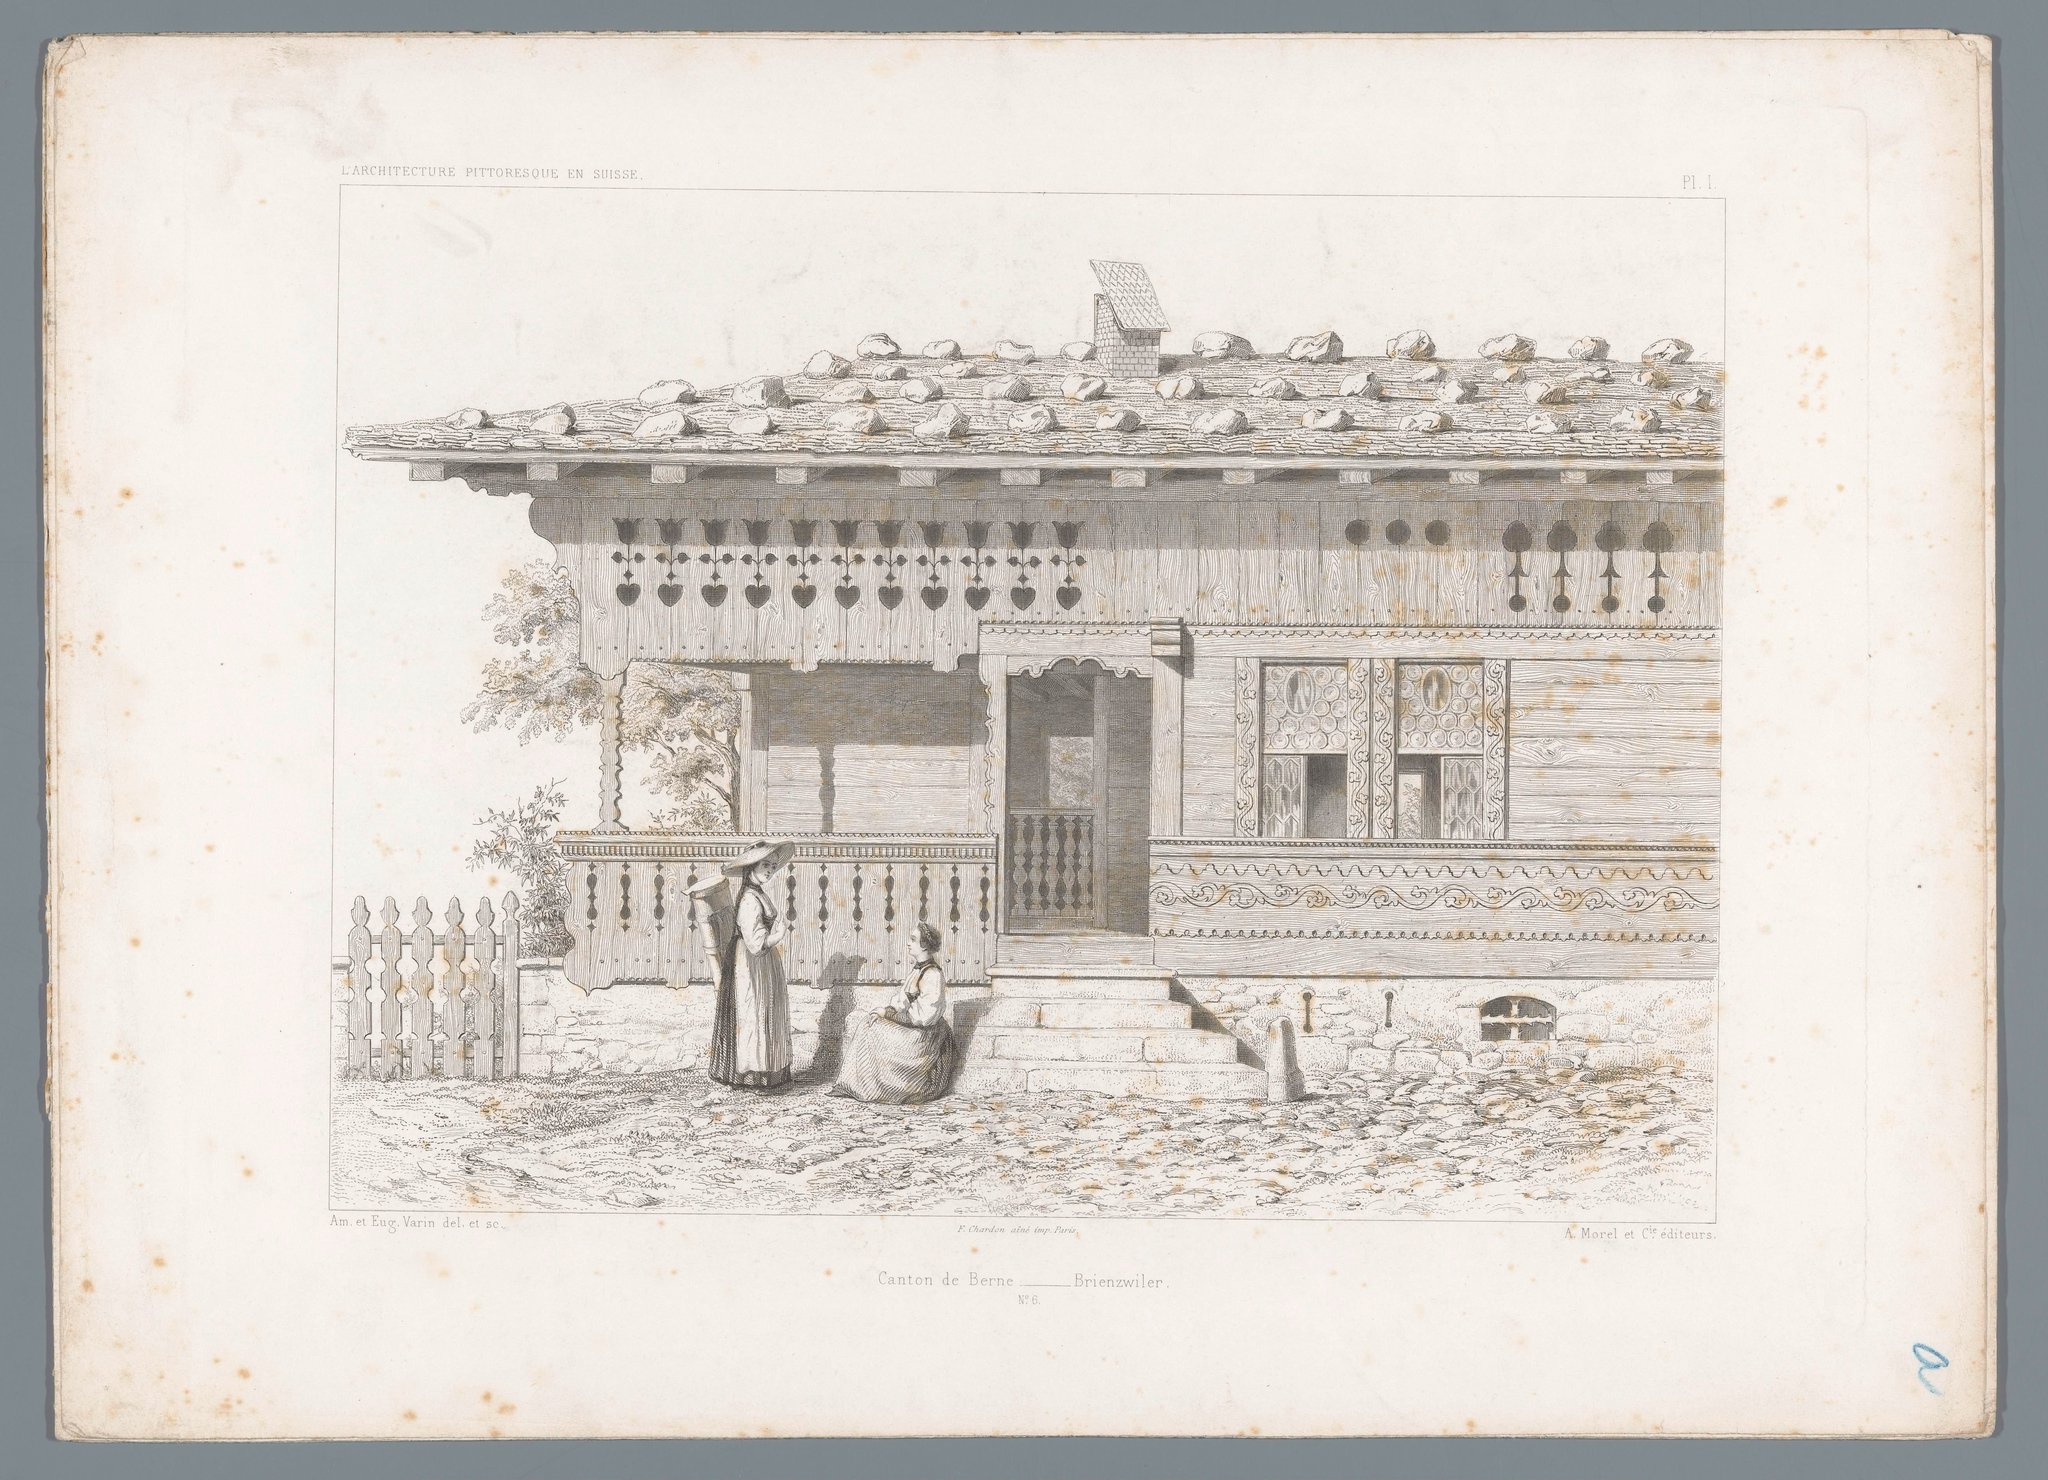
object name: print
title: L'Architecture Pittoresque en Suisse ou Choix de Constructions Rustiques (...)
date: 1860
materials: paper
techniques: engraving, etching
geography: france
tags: rural housing, e.g. country-house, villa, cottage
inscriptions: inscription: ‘a’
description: Prent afkomstig uit een serie van 48 prenten, uitgegeven tussen 1660-1661 in twaalf delen, getiteld: L'architecture pittoresque en Suisse ou choix de constructions rustiques prises dans toutes les parties de la Suisse. De serie bestaat uit aanzichten en details van traditionele Zwitserse huizen.